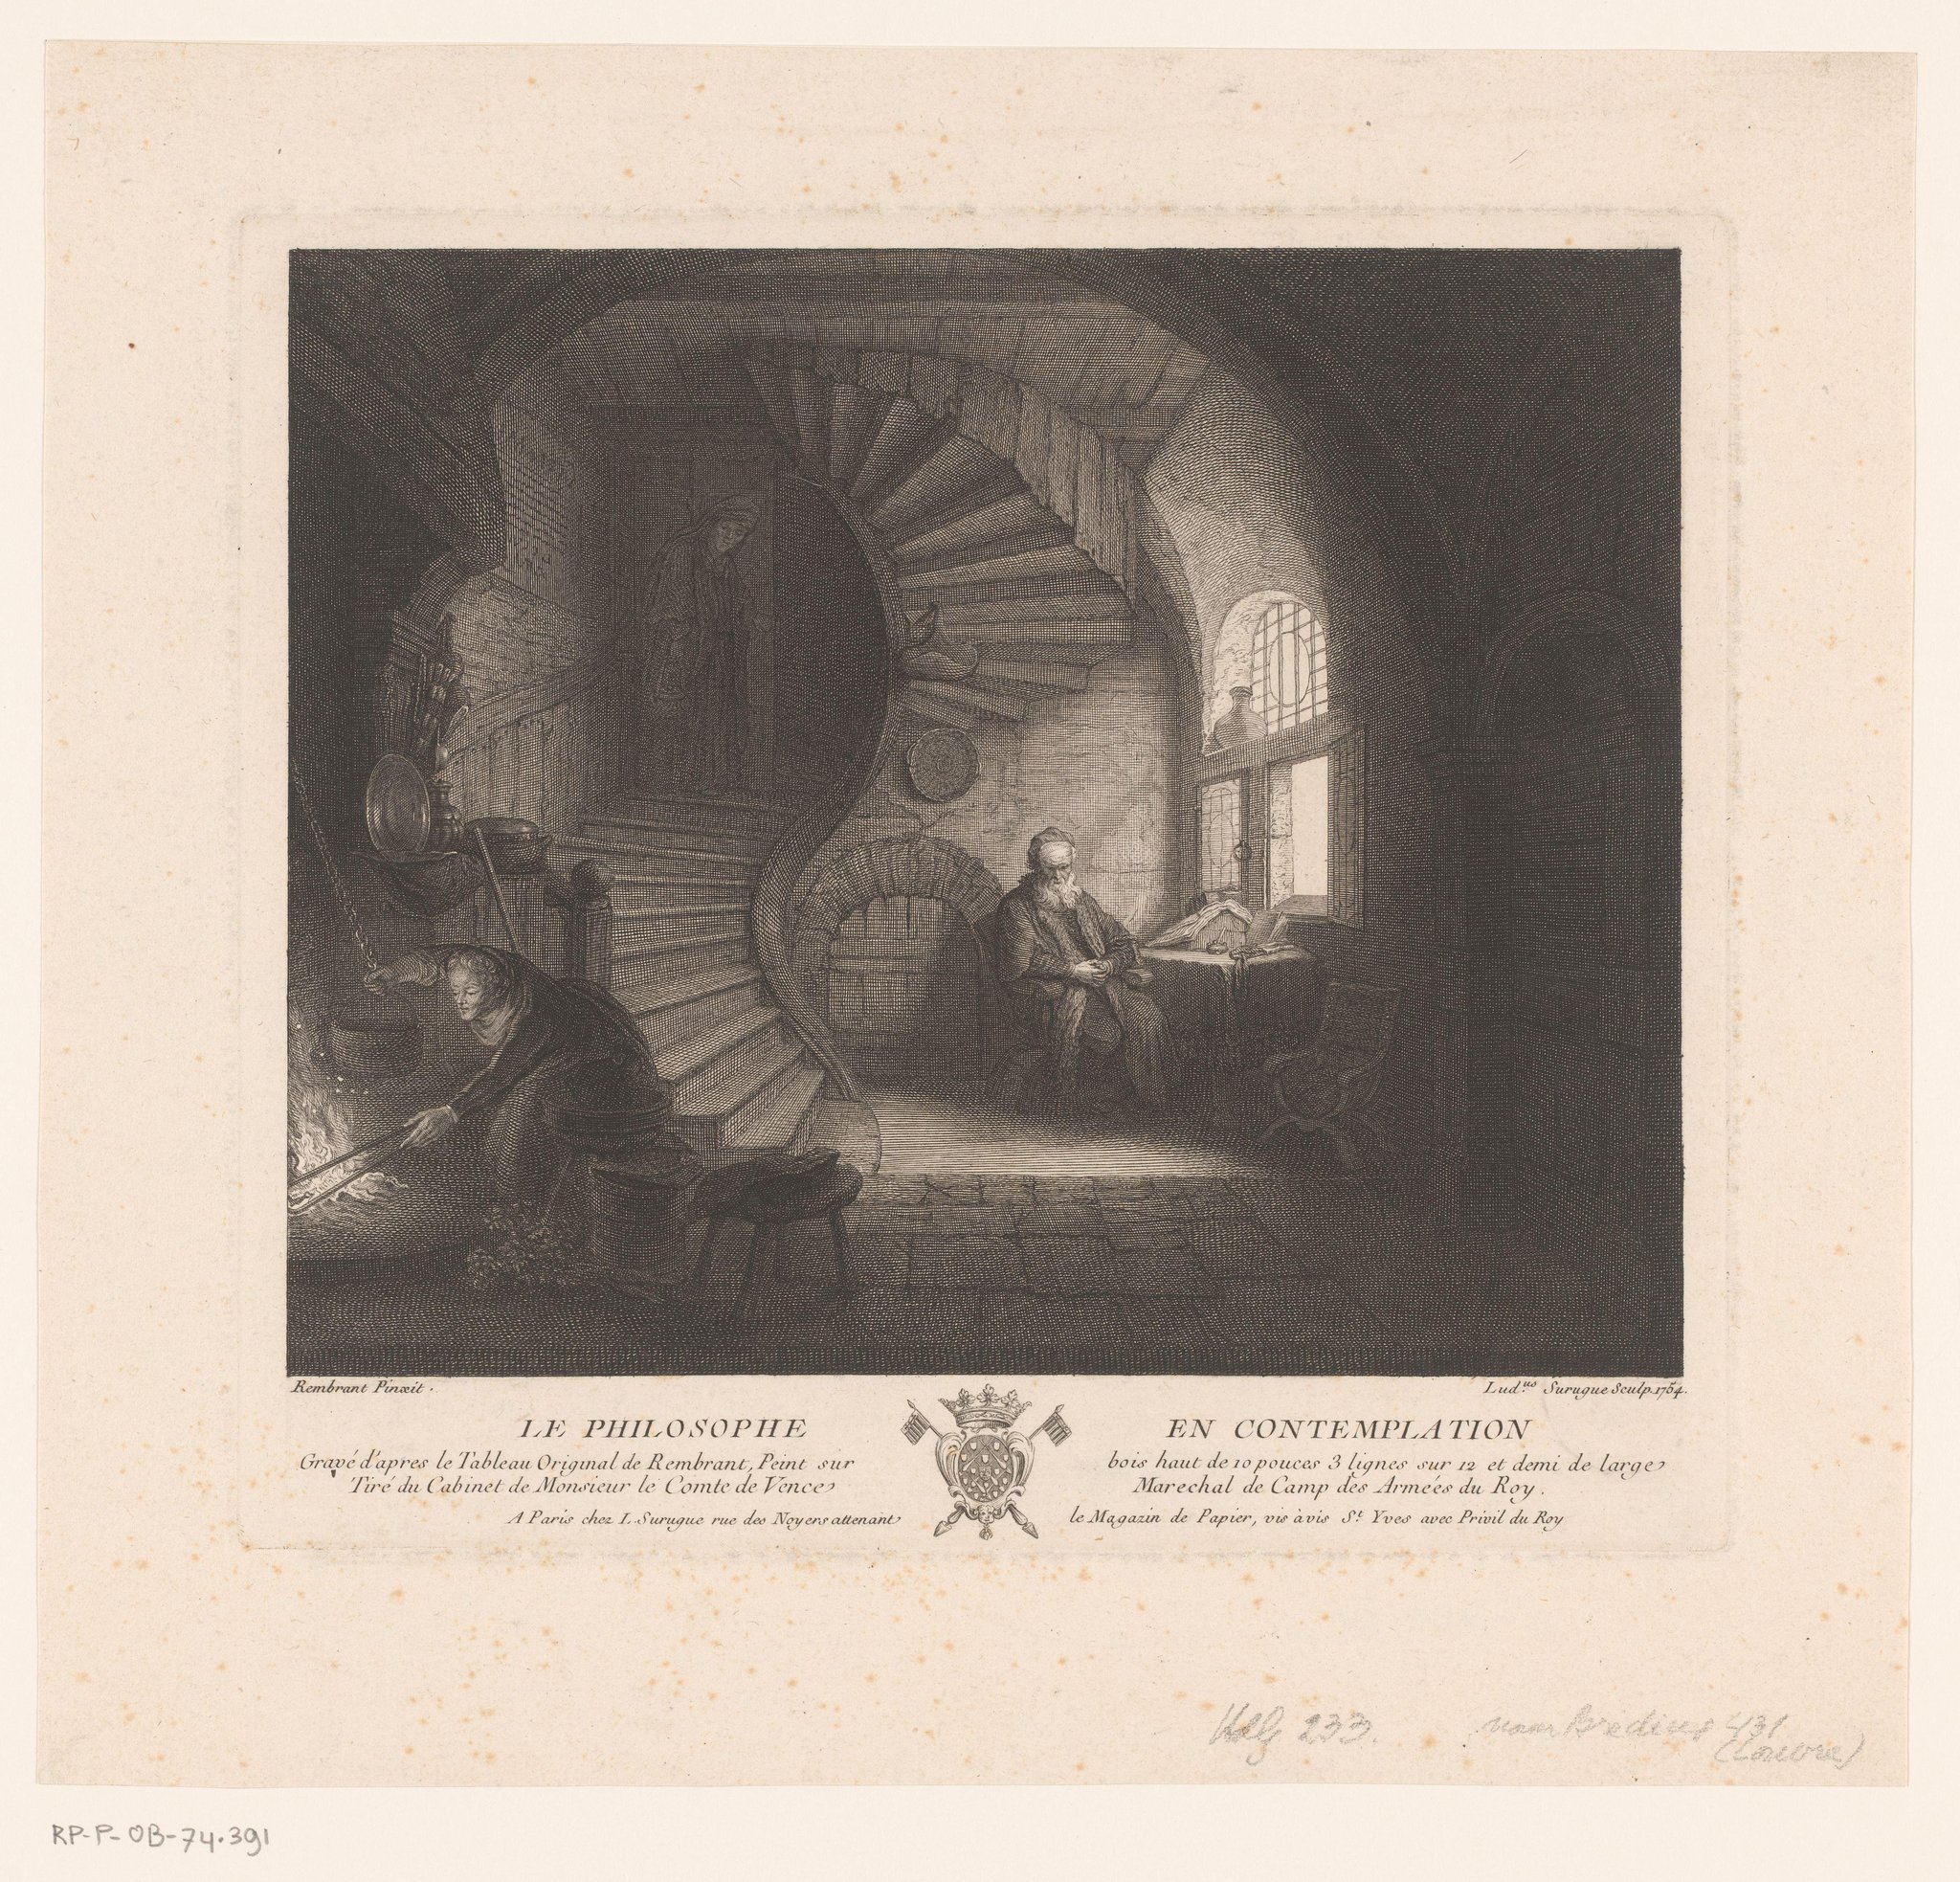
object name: print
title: La philosophe en contemplation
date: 1754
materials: paper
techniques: engraving, etching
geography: paris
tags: scholar, philosopher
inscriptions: collector's mark: Lugt 240